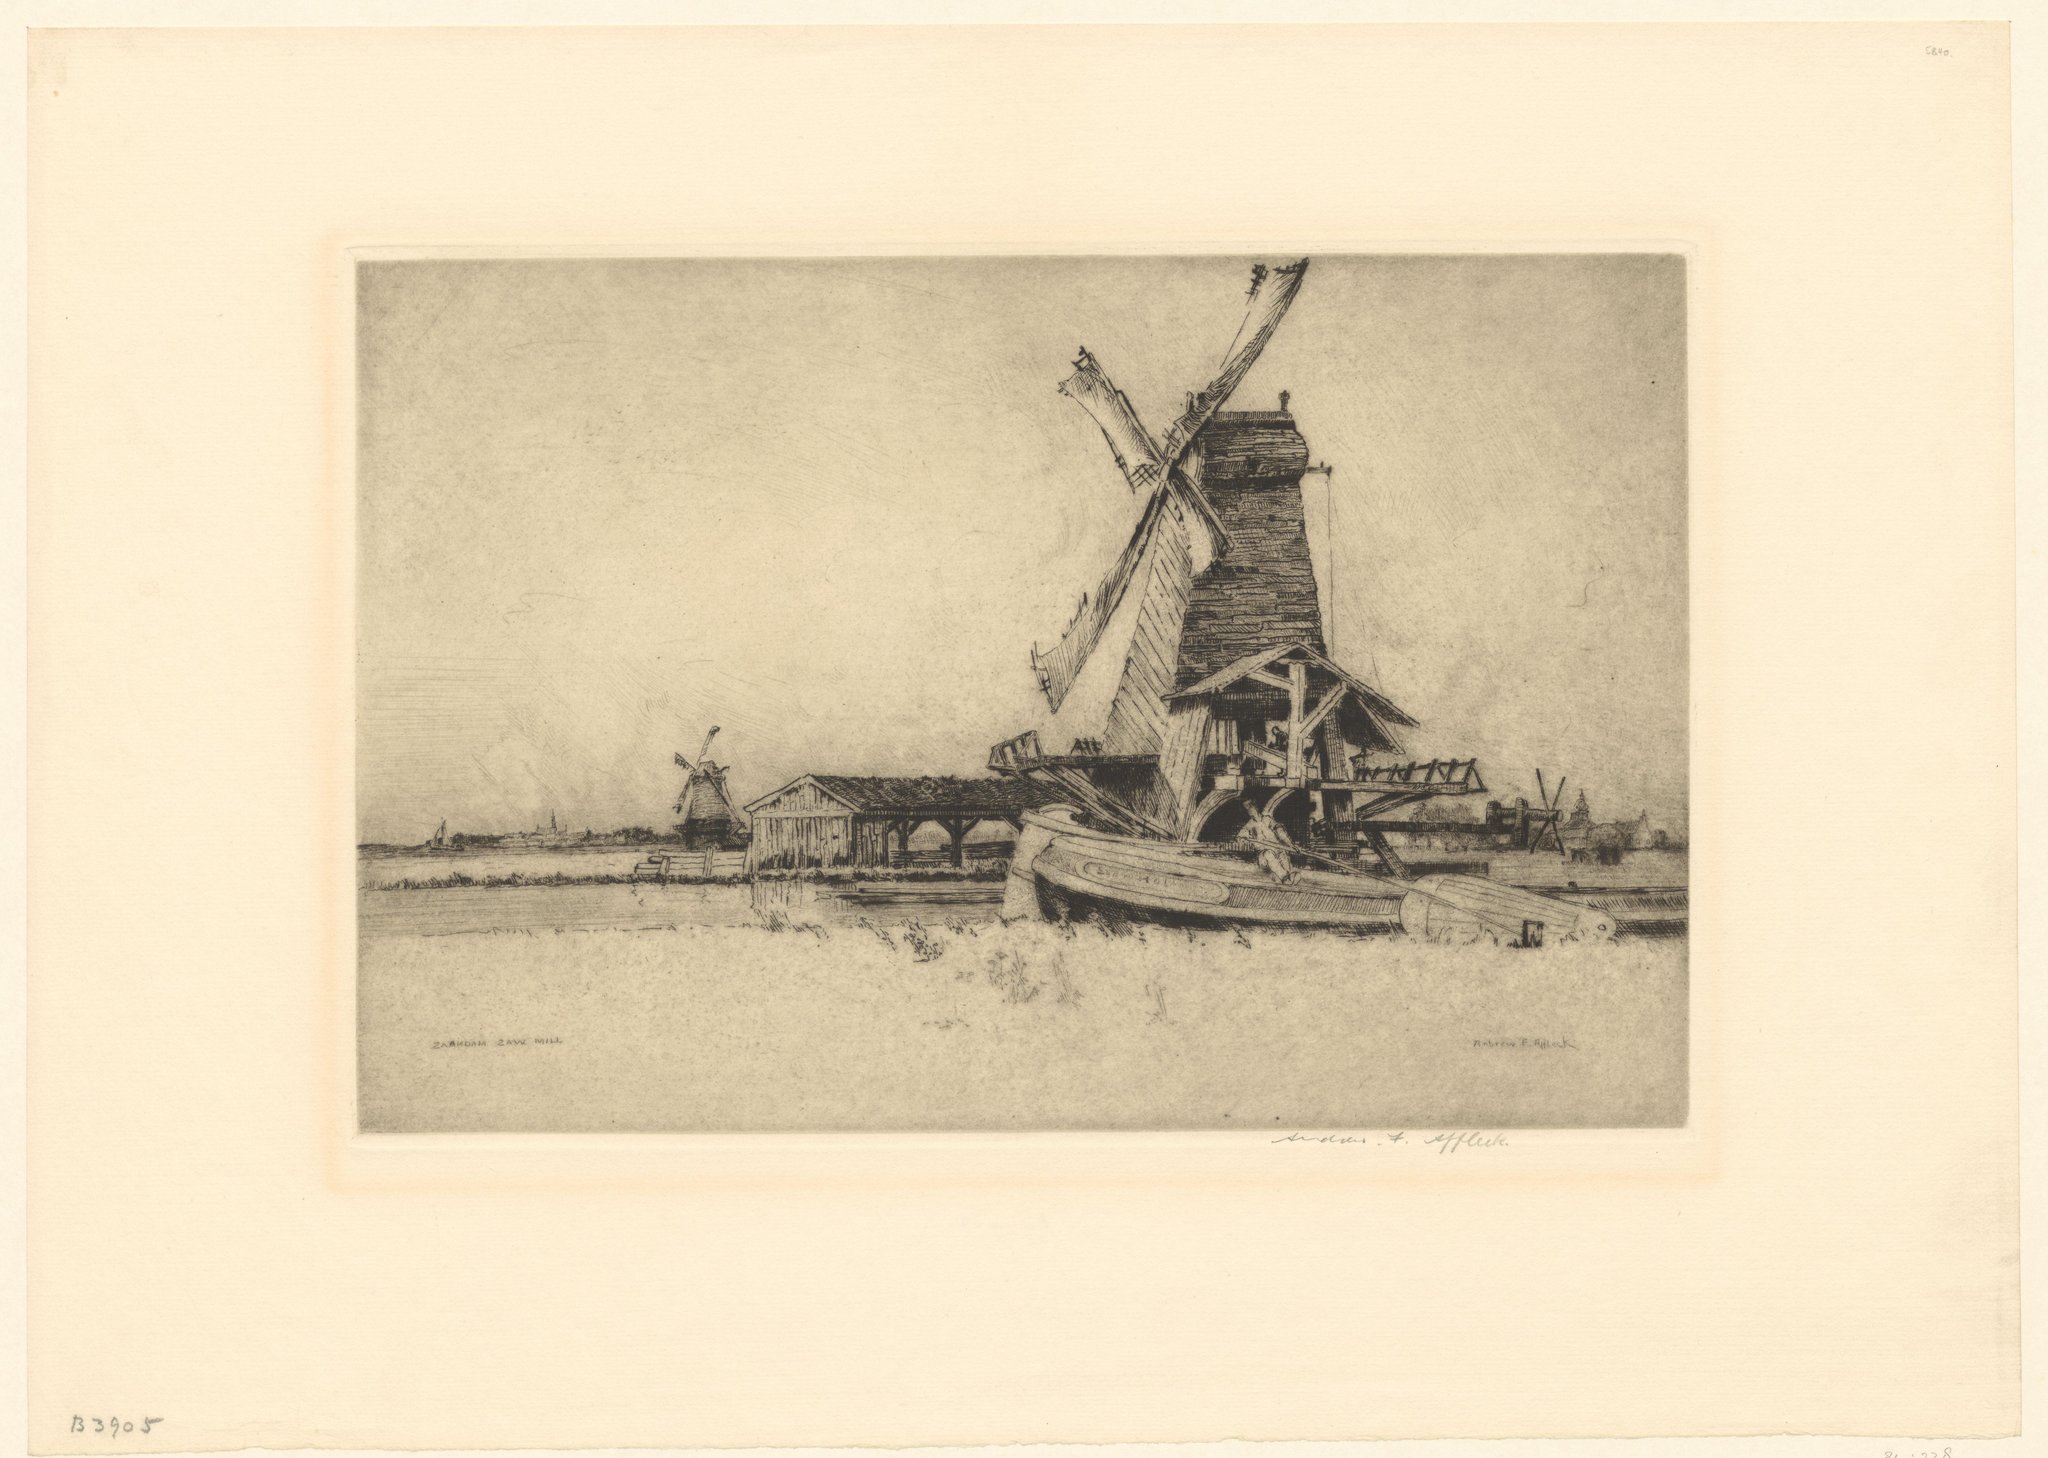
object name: print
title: Zaandam Zaw Mill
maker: andrew fairbairn affleck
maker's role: print maker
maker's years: 1874-1936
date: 1900-1910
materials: paper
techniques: drypoint, etching, intaglio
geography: zaanstad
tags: saw-mill (works), windmill in landscape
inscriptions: collector's mark: Lugt 2228, collector's mark: Lugt 2760